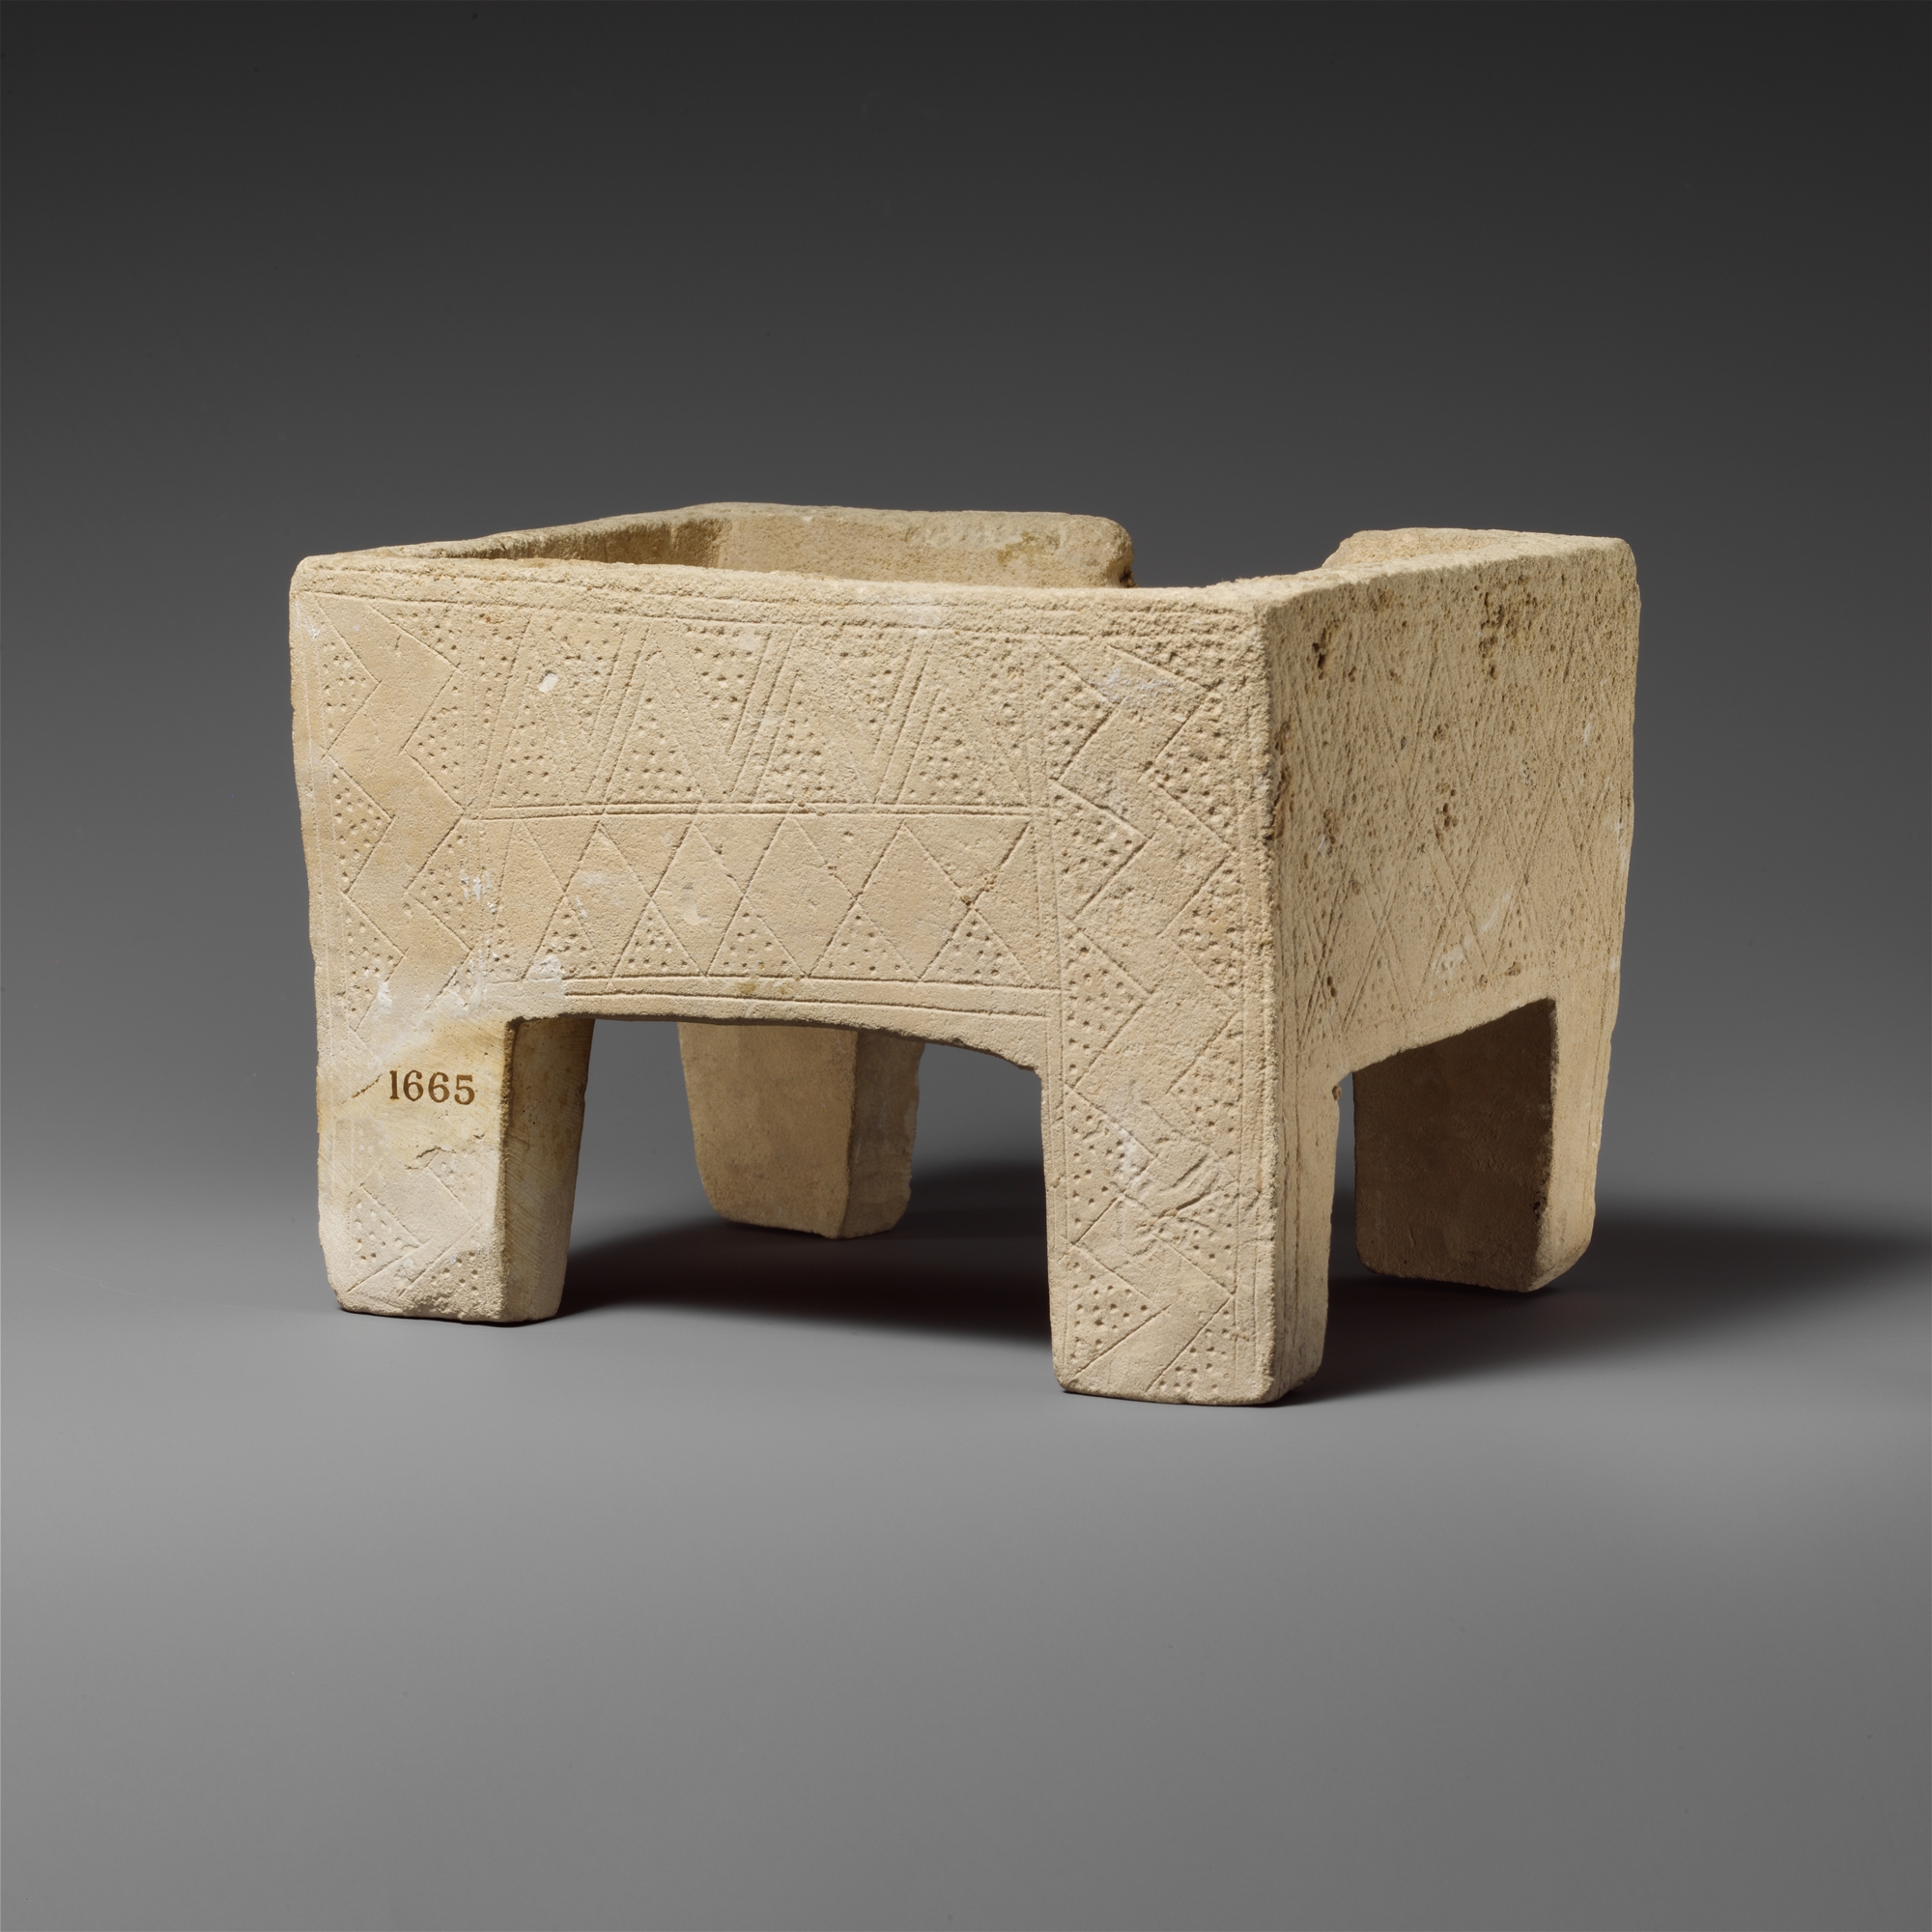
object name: chest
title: Limestone chest with incised decoration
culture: cypriot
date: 800-501 BCE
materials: limestone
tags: chests